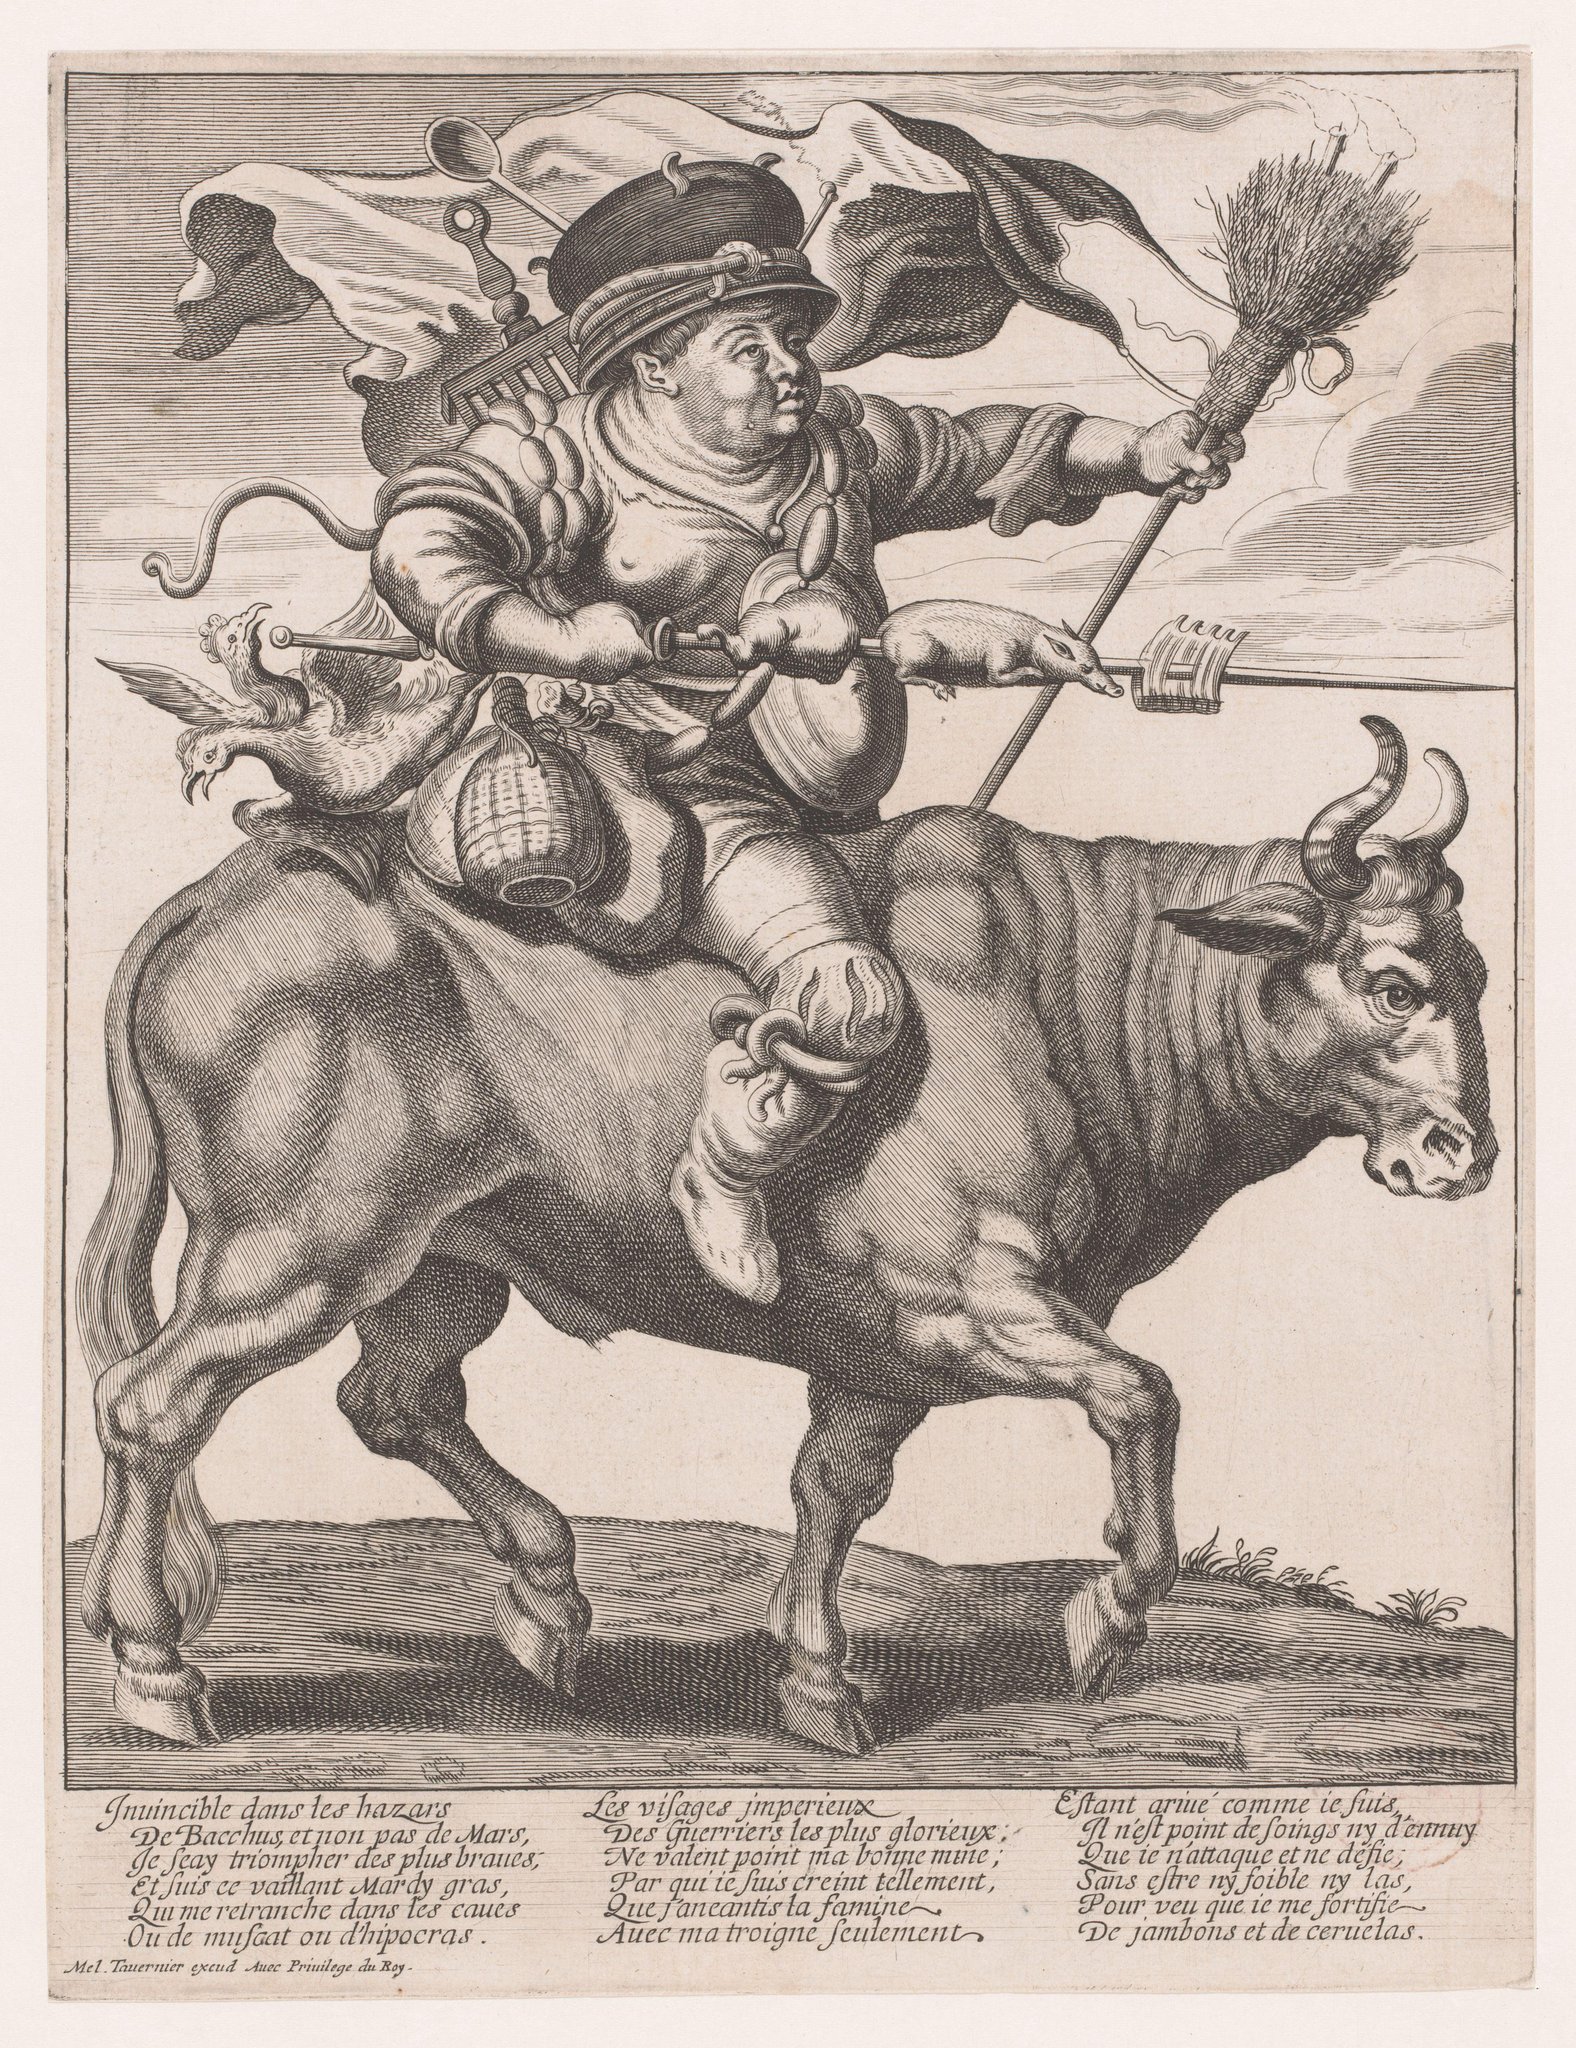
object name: print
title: Man overladen met huisraad op rund gezeten met carnaval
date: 1574-1641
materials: paper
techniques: engraving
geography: france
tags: ox, meat; still life of meat, (household) utensils and implements, shrove tuesday, 'mardi gras' ~ non-liturgical celebrations of carnival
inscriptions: collector's mark: Lugt 240